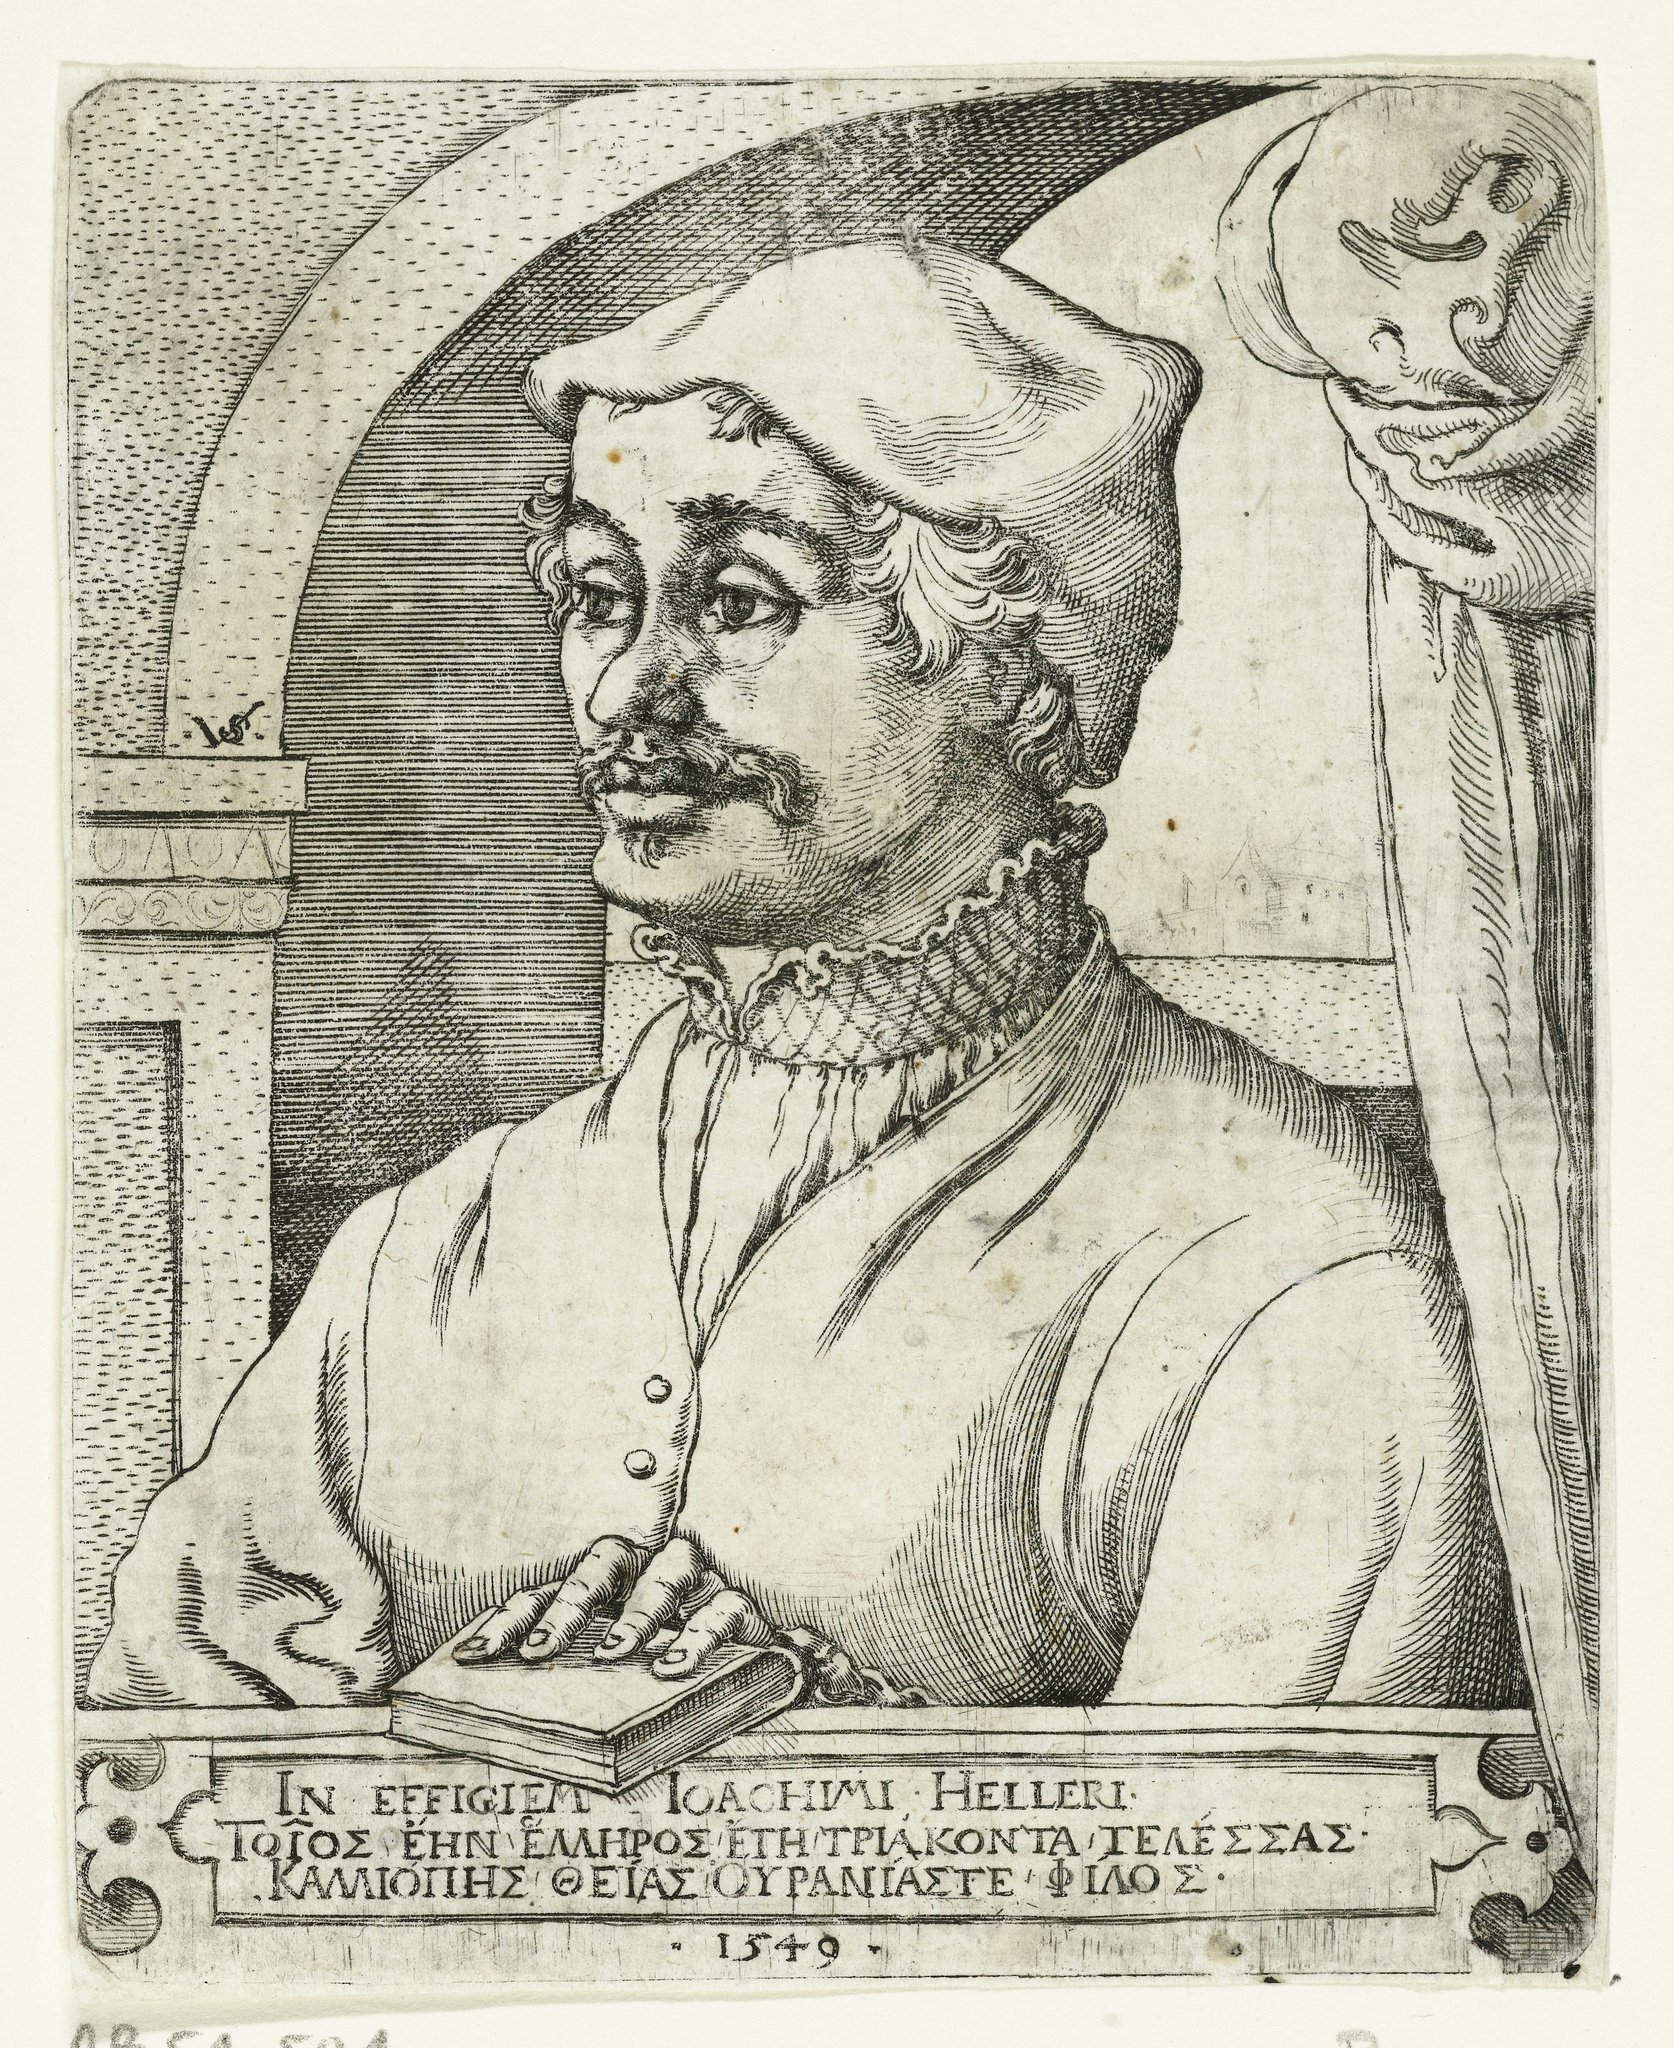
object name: print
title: Portret van Joachim Heller met boek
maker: virgilius solis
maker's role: draughtsman, print maker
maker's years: 1514-1562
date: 1524-1562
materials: paper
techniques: engraving, intaglio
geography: nuremberg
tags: moustache, historical persons, book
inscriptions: number: ‘105’, collector's mark: Lugt 2228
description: kleding: hemd met hoog opstaande gesmokte kraag. Op het hoofd een bonnet zonder rand, waaronder kort geknipte haren. Heller draagt een snor.